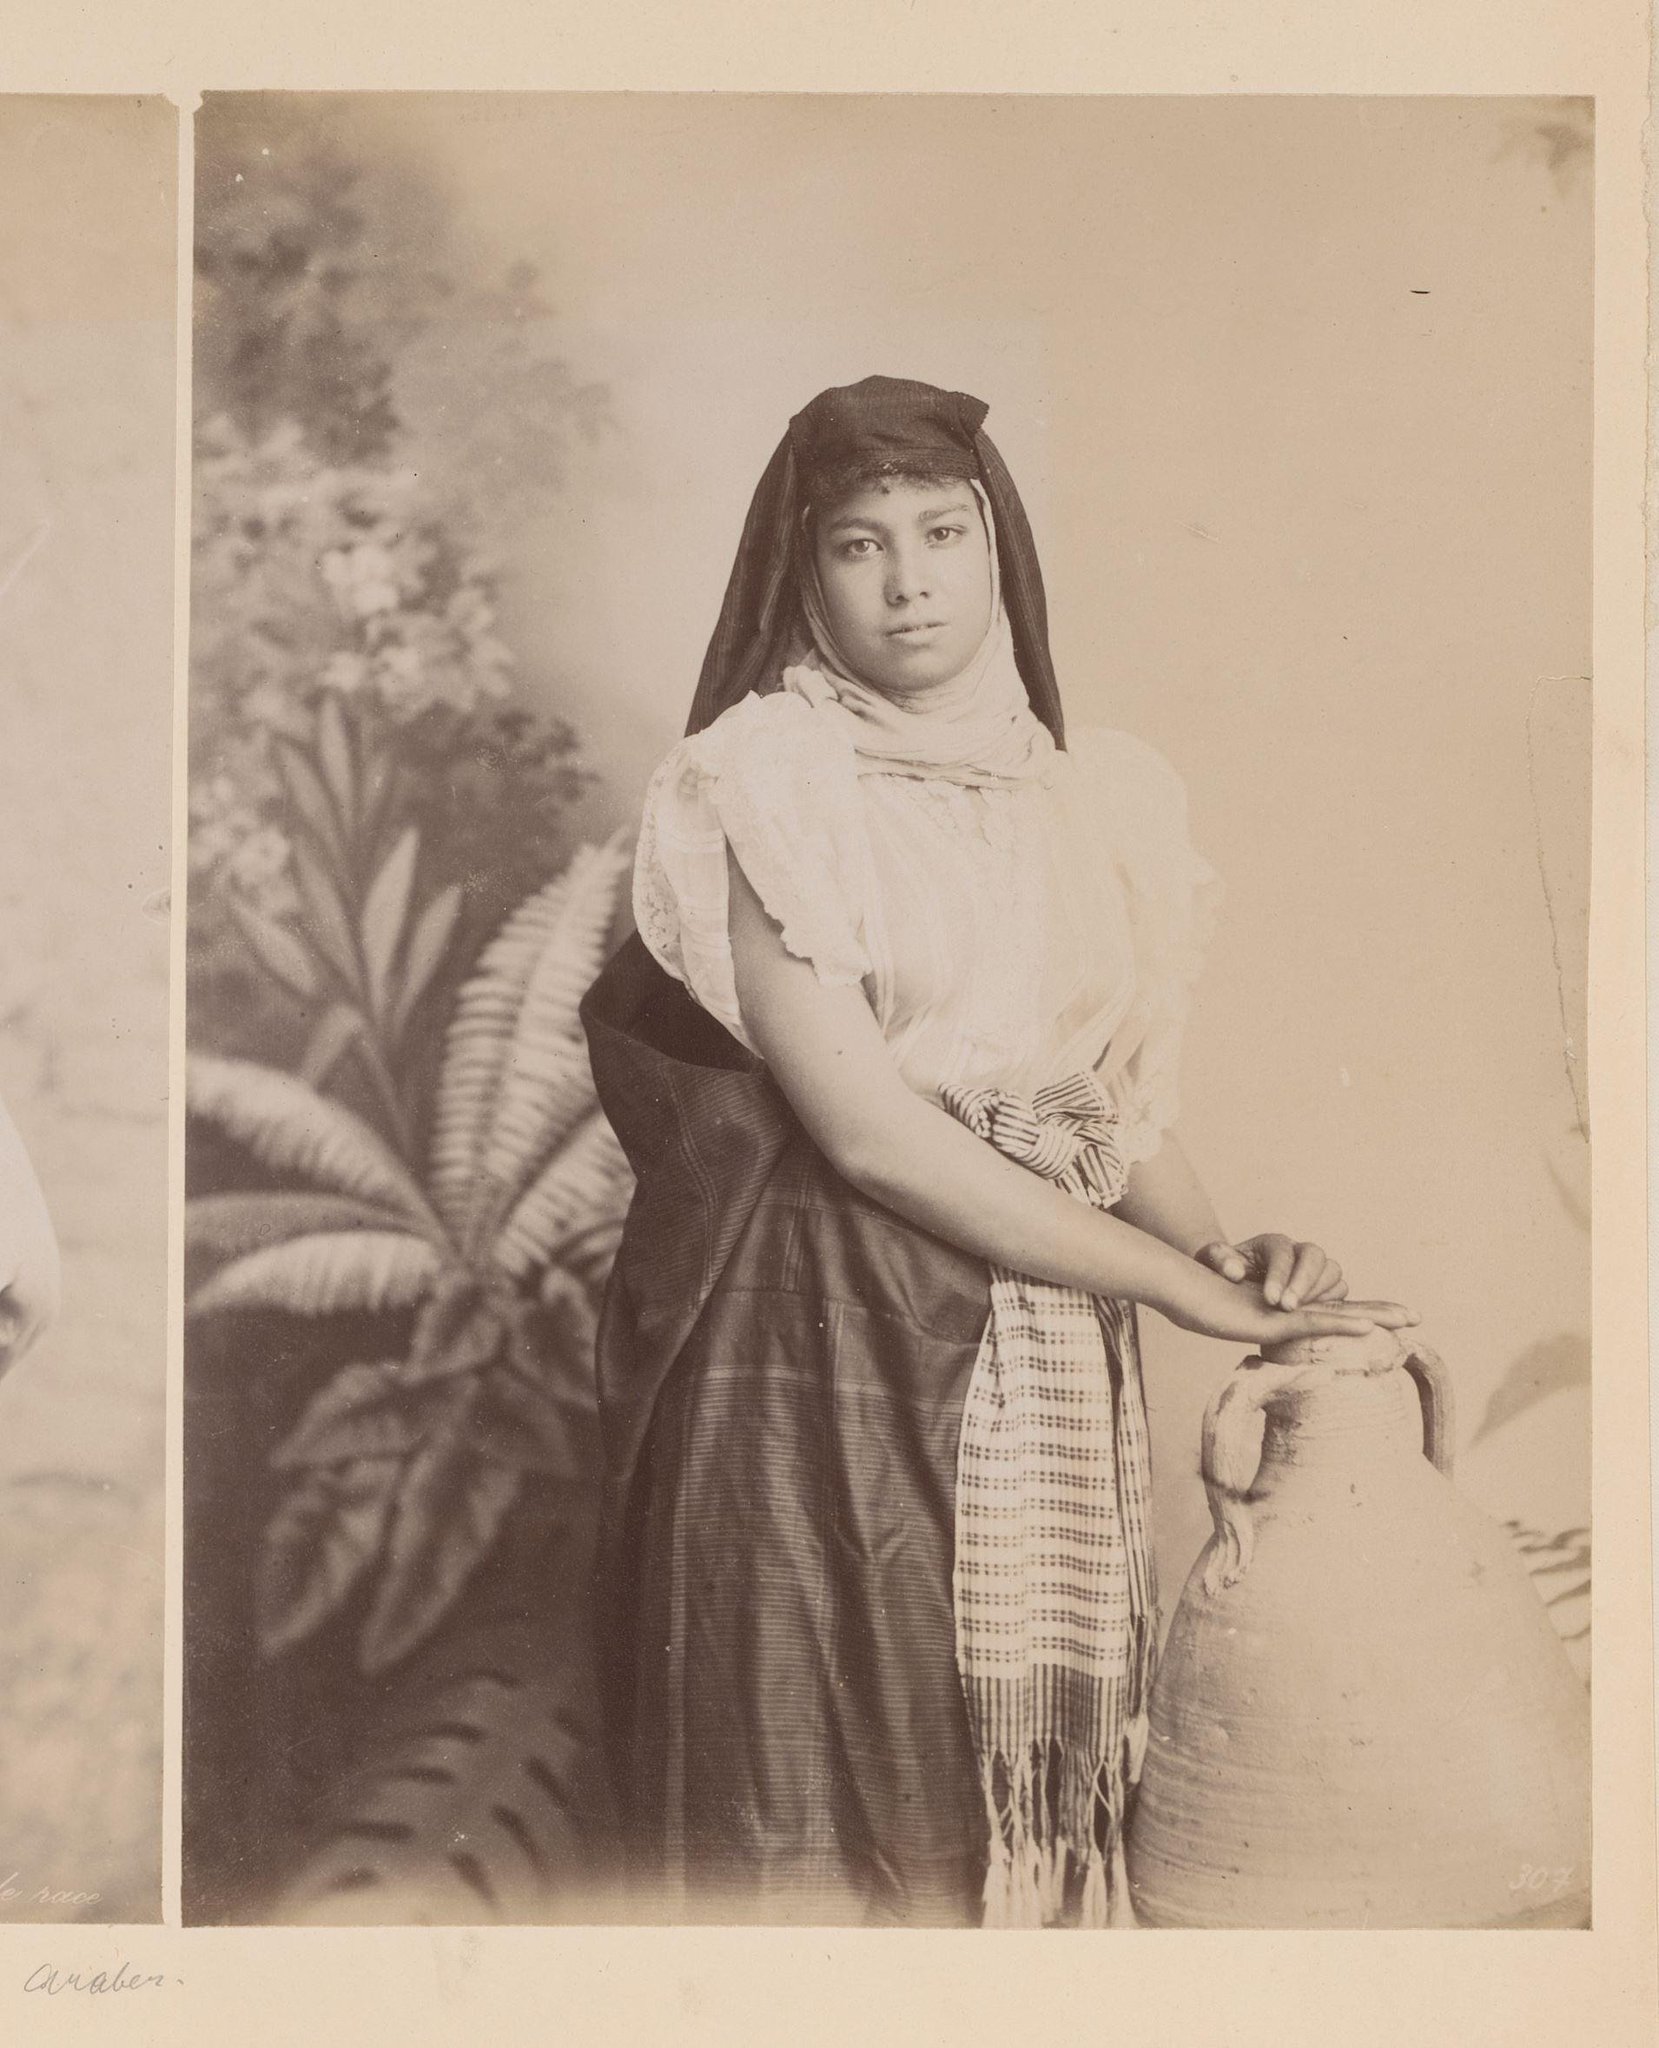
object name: photograph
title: Portret van een Arabische vrouw leunend op een kan, Egypte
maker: Anonymous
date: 1890-1900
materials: cardboard, photographic support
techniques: albumen print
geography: egypt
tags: historical persons - bb - woman, container of ceramics: jar, jug, pot, vase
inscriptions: number: ‘307’